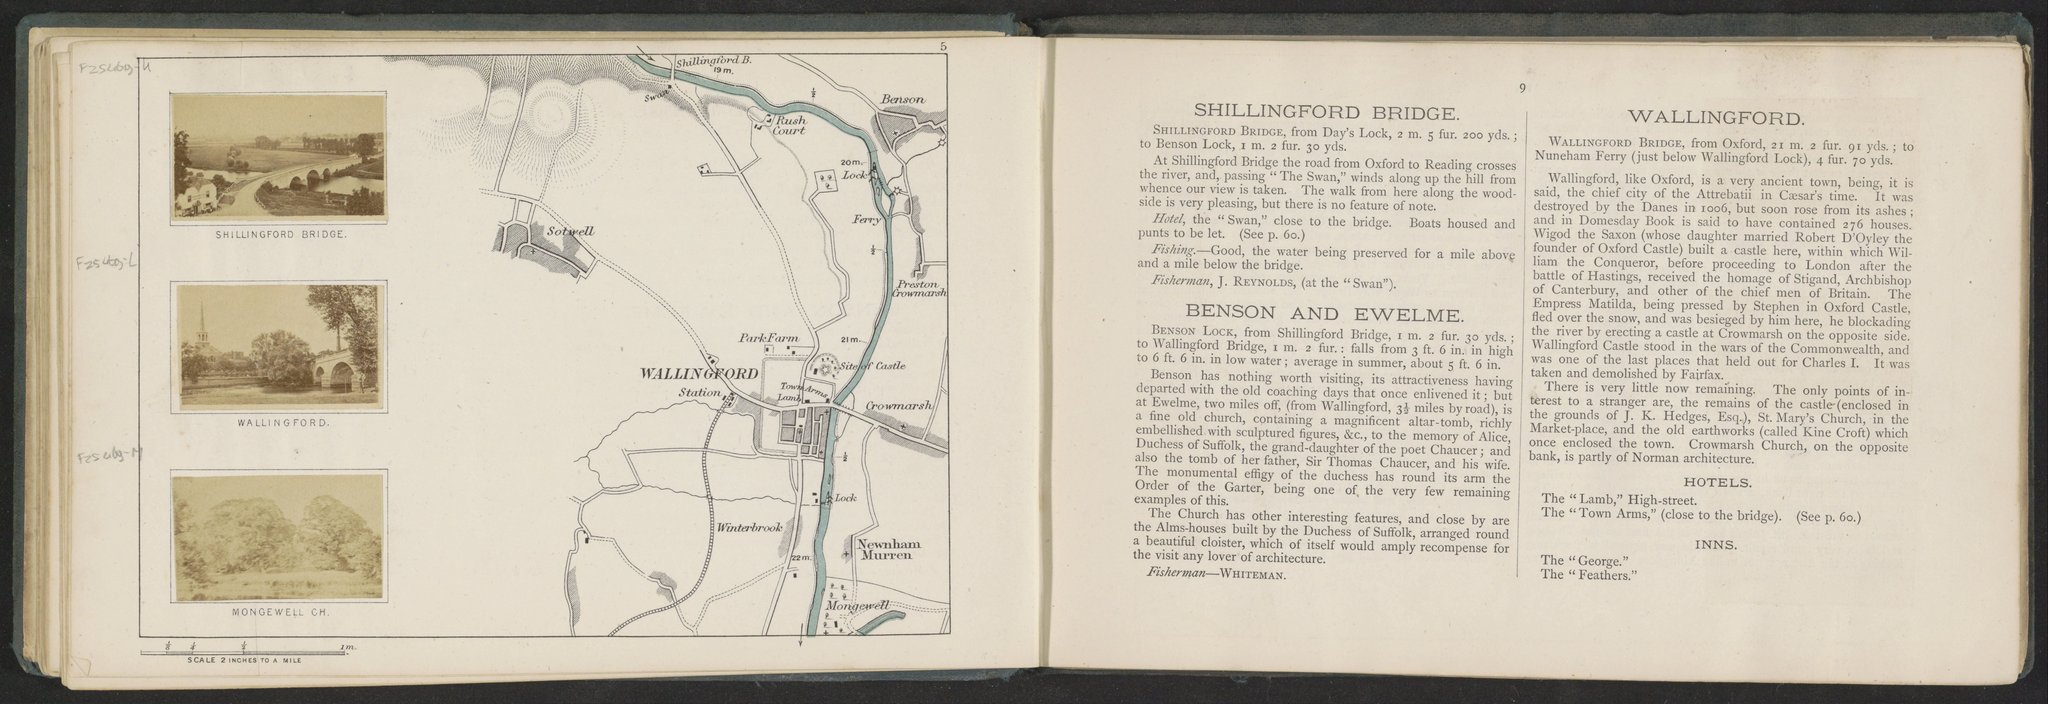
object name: page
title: Gezicht op vermoedelijk een park in Mongewell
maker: henry w. taunt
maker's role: fotograaf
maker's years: 1842-1922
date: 1871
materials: photographic support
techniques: albumen print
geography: mongewell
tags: park, river, thames